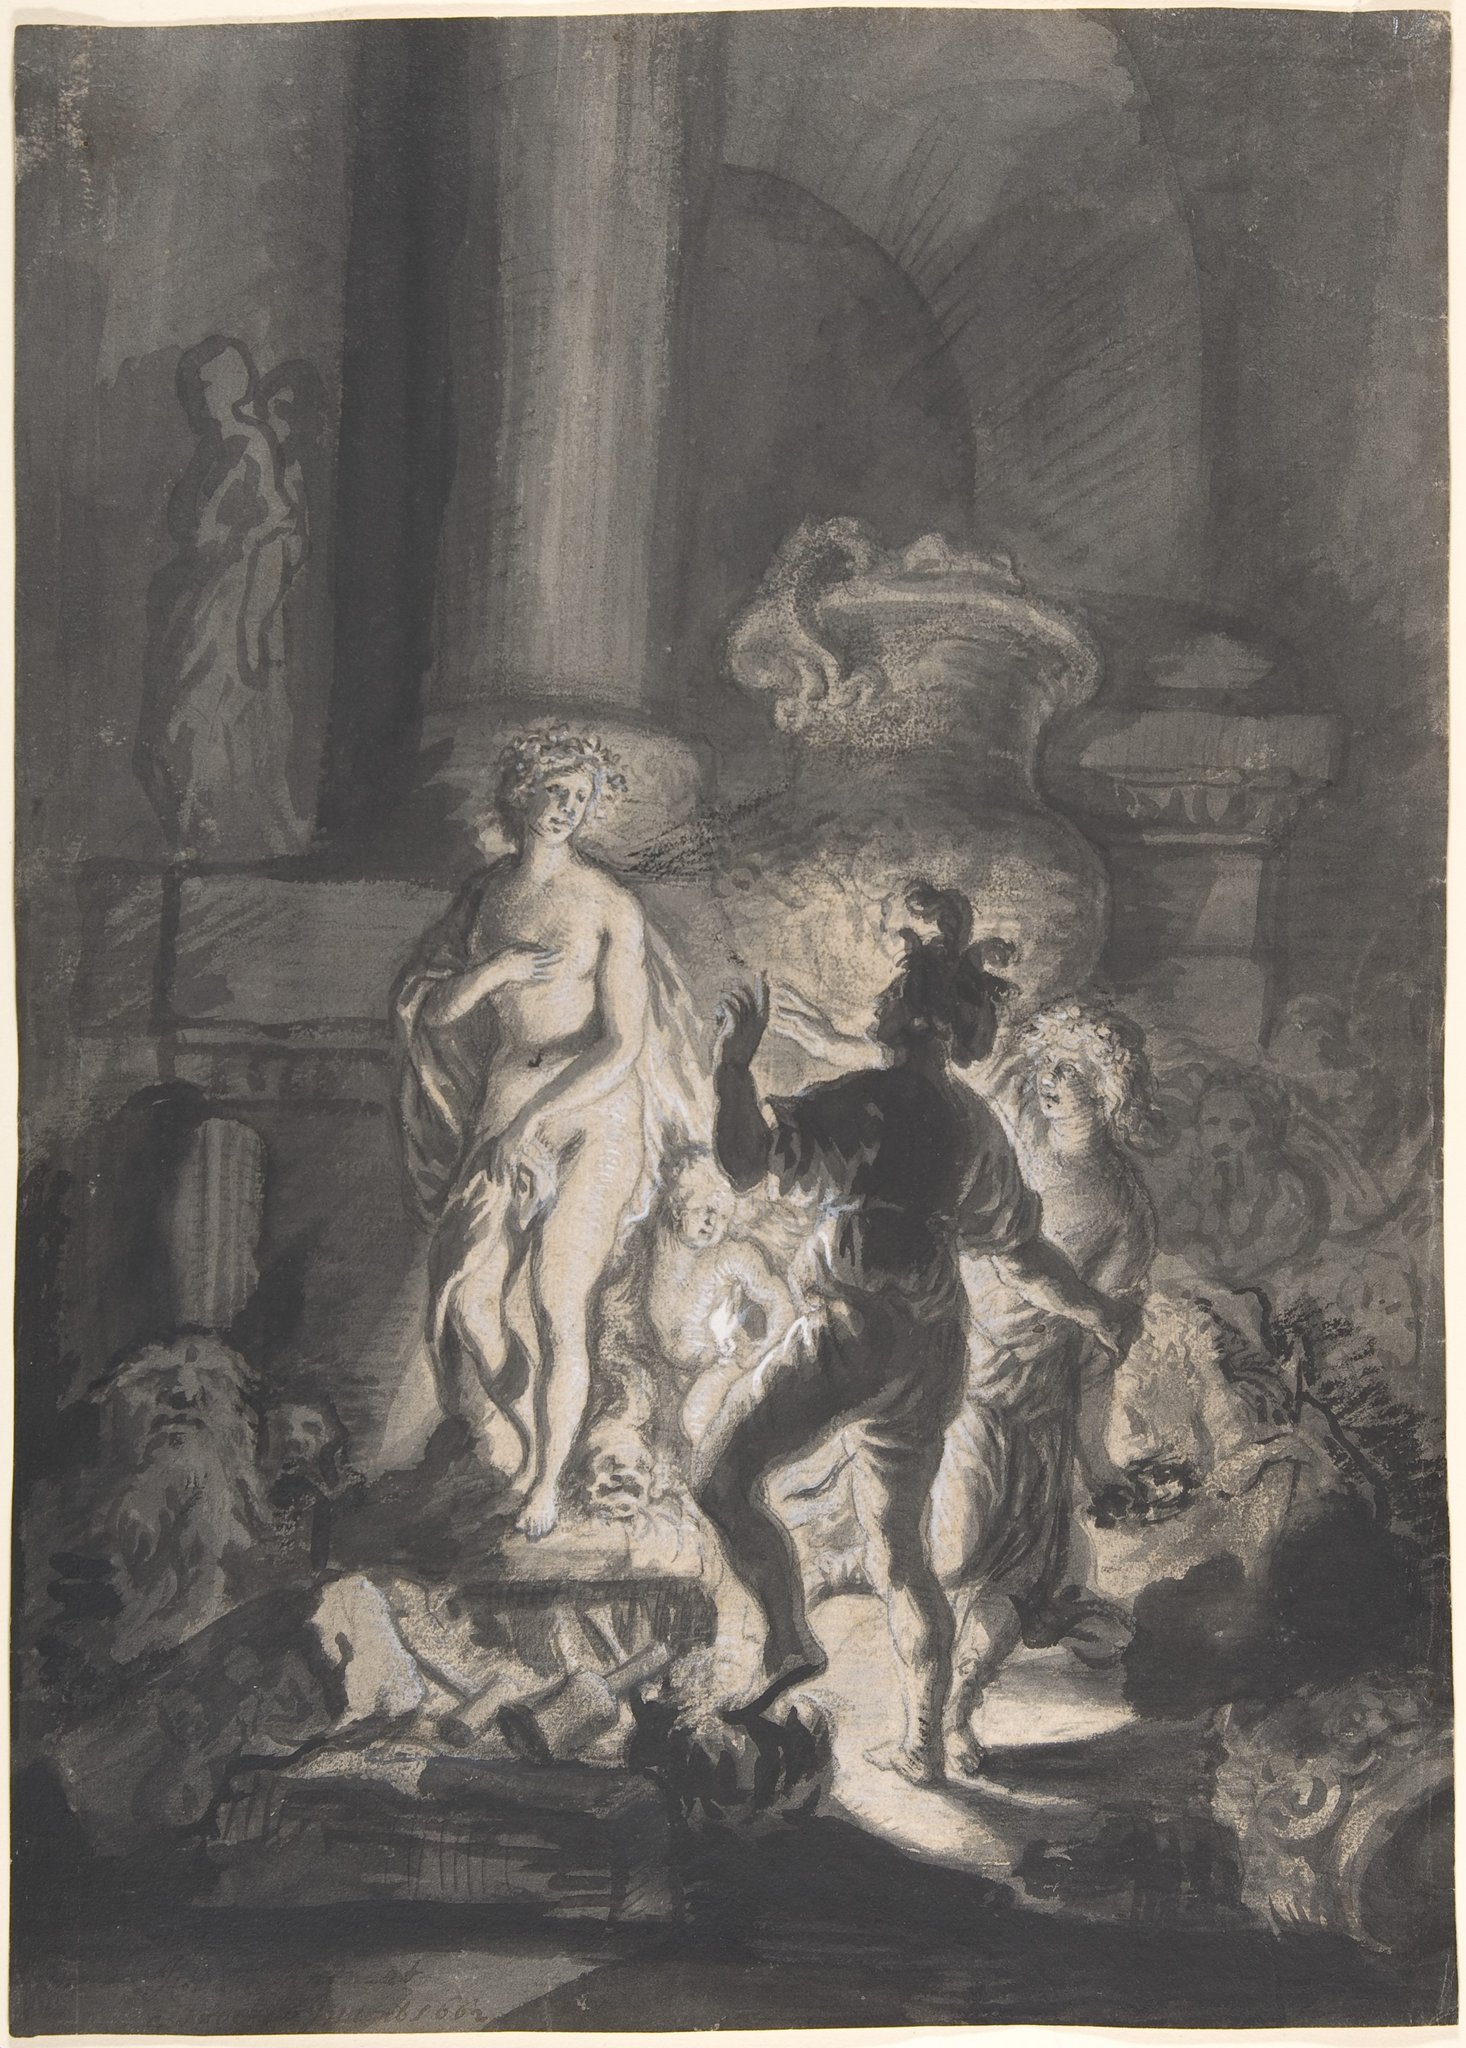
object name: drawing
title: Pygmalion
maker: joachim von sandrart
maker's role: artist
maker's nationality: german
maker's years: 1606-1688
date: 1662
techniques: brush, heightening, wash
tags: men,female nudes,galatea,pygmalion